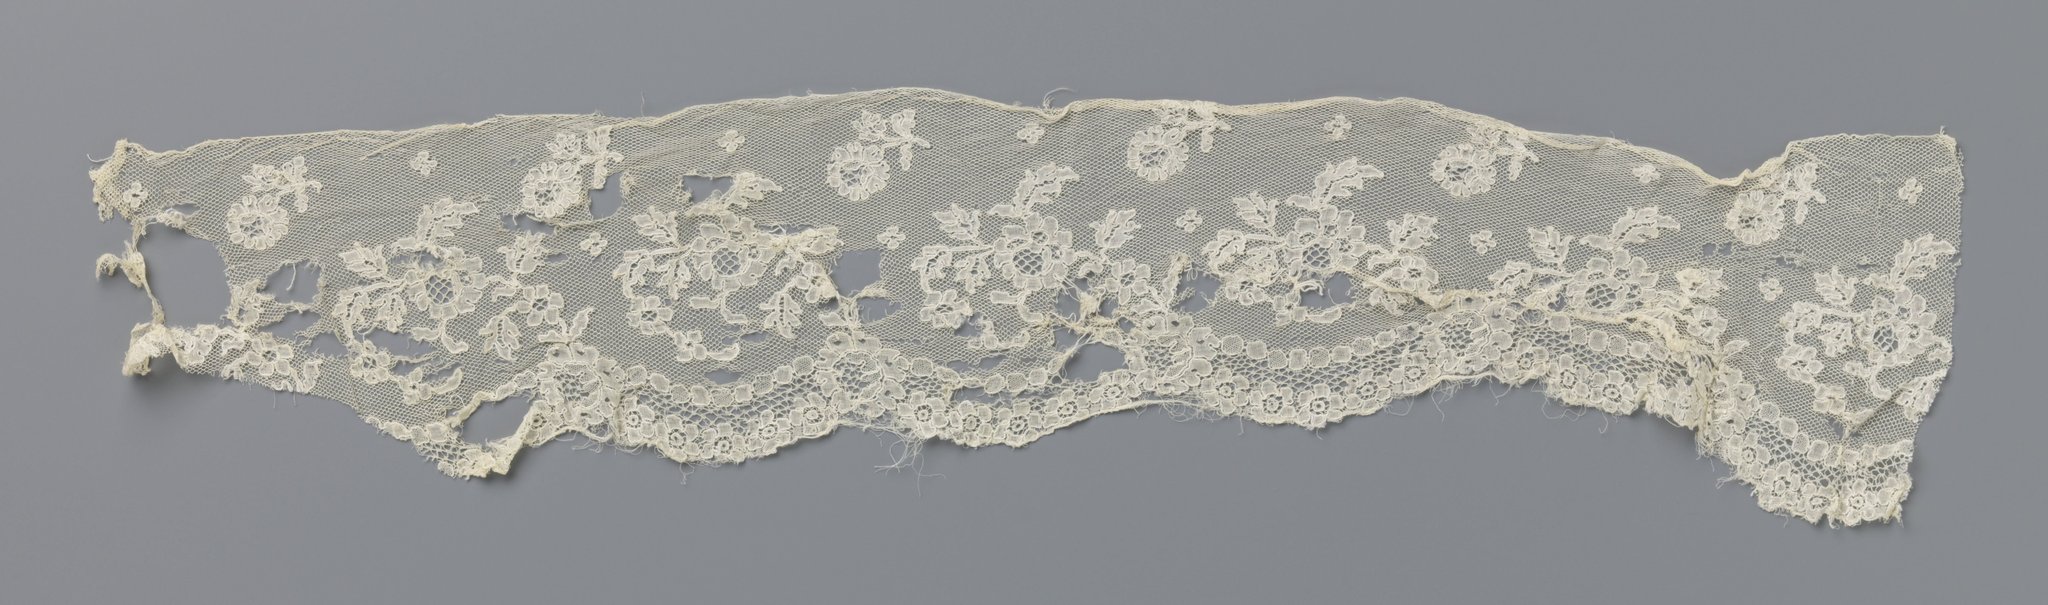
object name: strip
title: Strook kloskant met parel- en rozetlijst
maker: Anonymous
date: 1830-1850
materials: linen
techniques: lace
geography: ieper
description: Op de traliegrond, een Mechelse grond (ook wel ijsgrond genoemd), met enkele gestrooide vierpasvormige moesjes staat een lopend patroon. Langs de binnenkant staan kleine hangende rozetakjes, in het midden een duinroosje aan grotere voluutstengels, die ontspringen bij dezelfde bloem die het sluitstuk der zuiver cirkelboogvormige schulpen vormt. De schulpen bestaan uit een parel- en rozetlijst, die een middenbaan met rasterwerk insluiten. Mechelse kant.